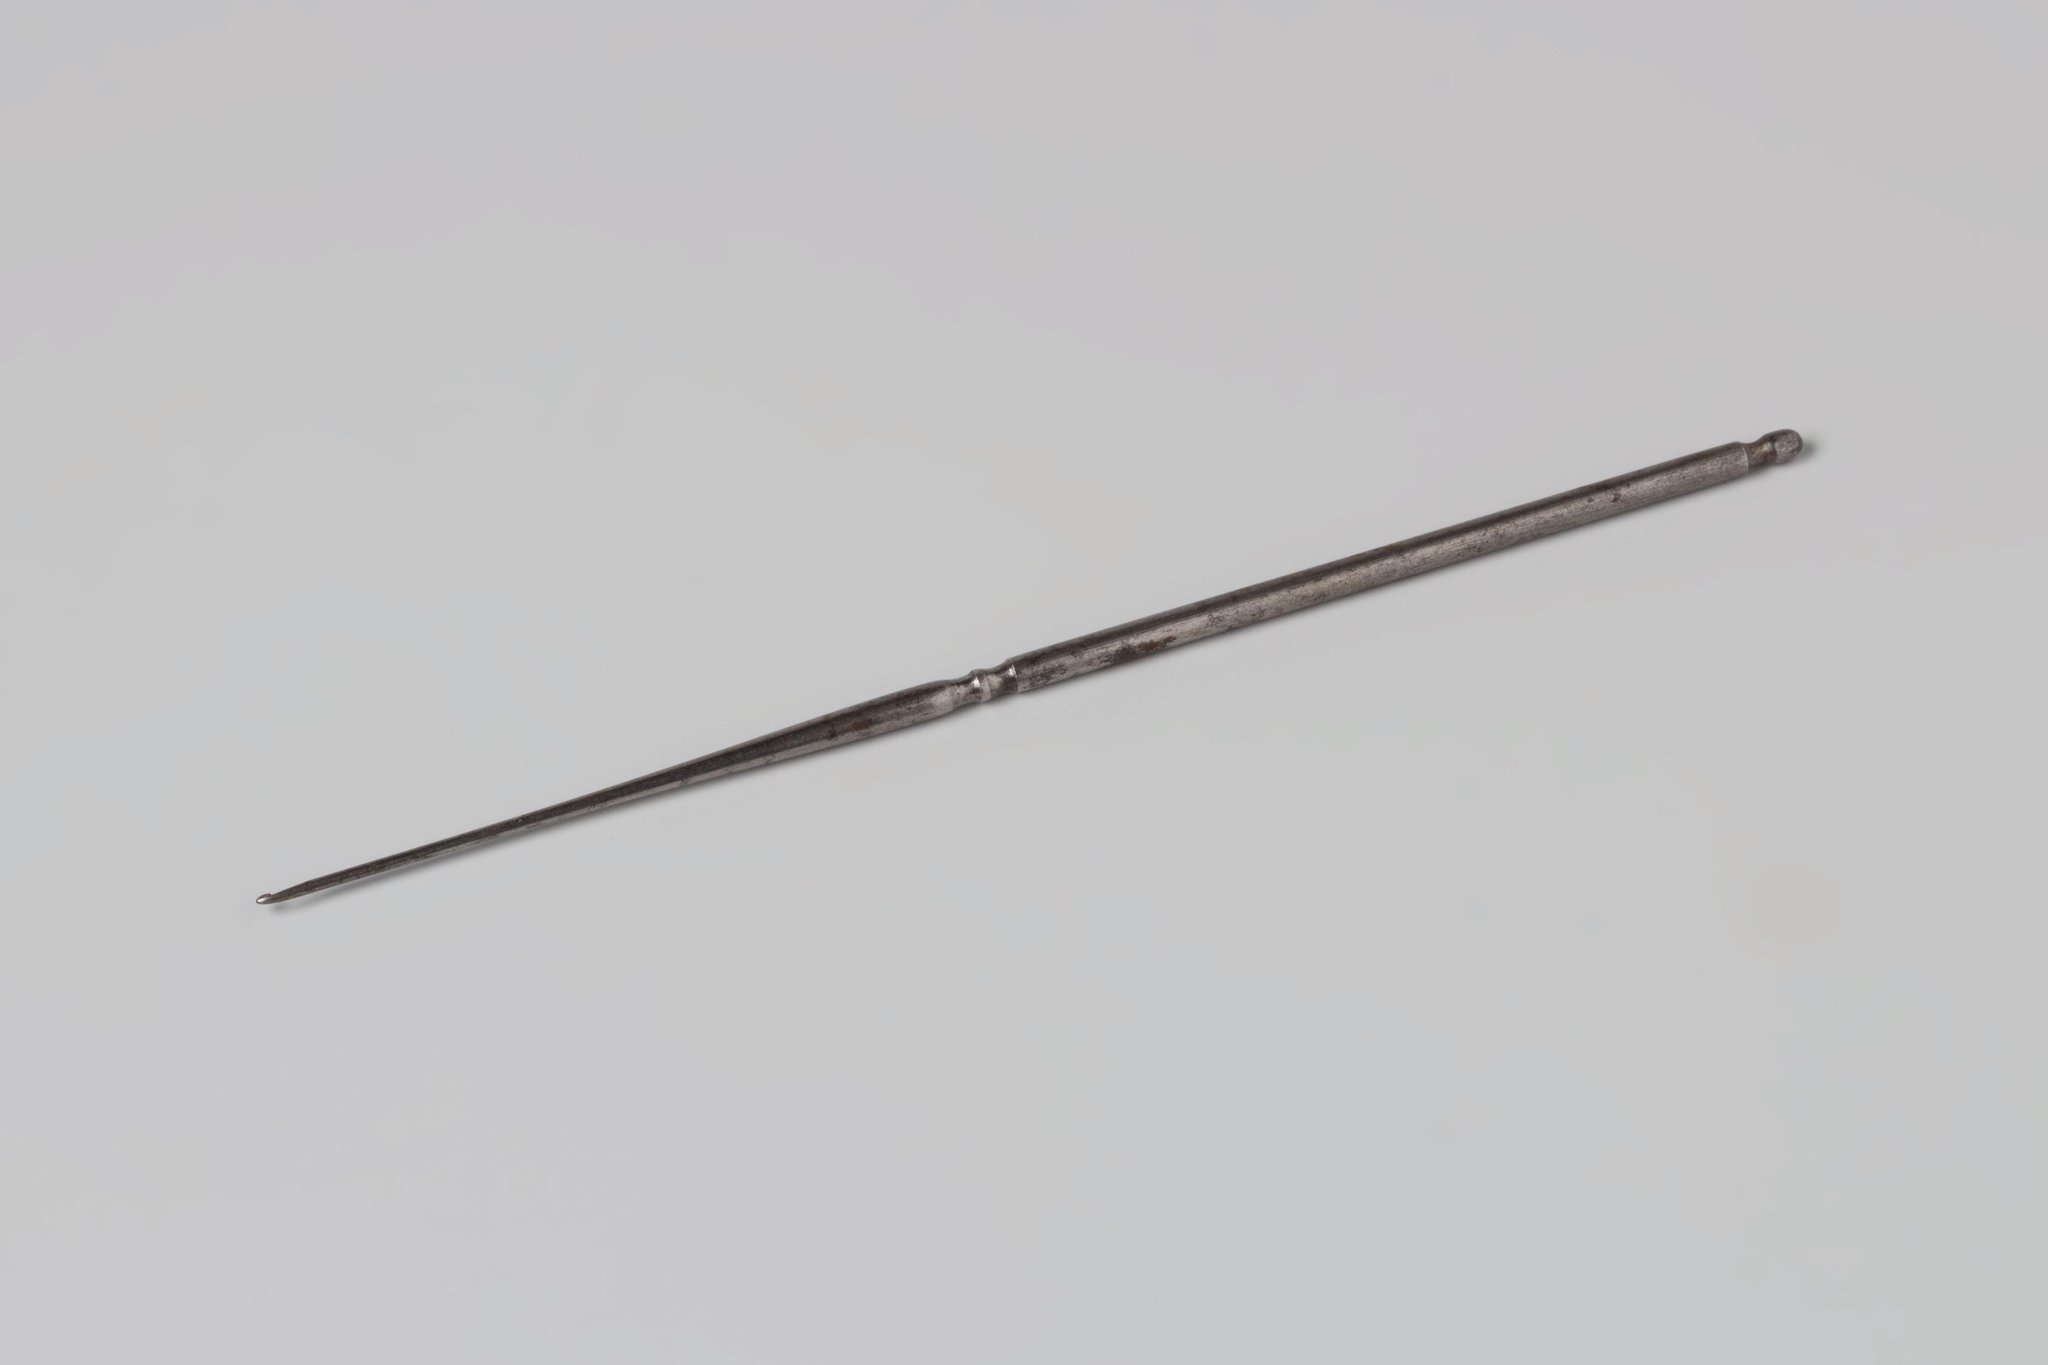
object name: textile working equipment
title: Haakpen van staal met knop en geleding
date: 1900-1950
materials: steel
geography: germany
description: Een haakpen van staal met knop en geleding. Adres: Imra / Geschützt.